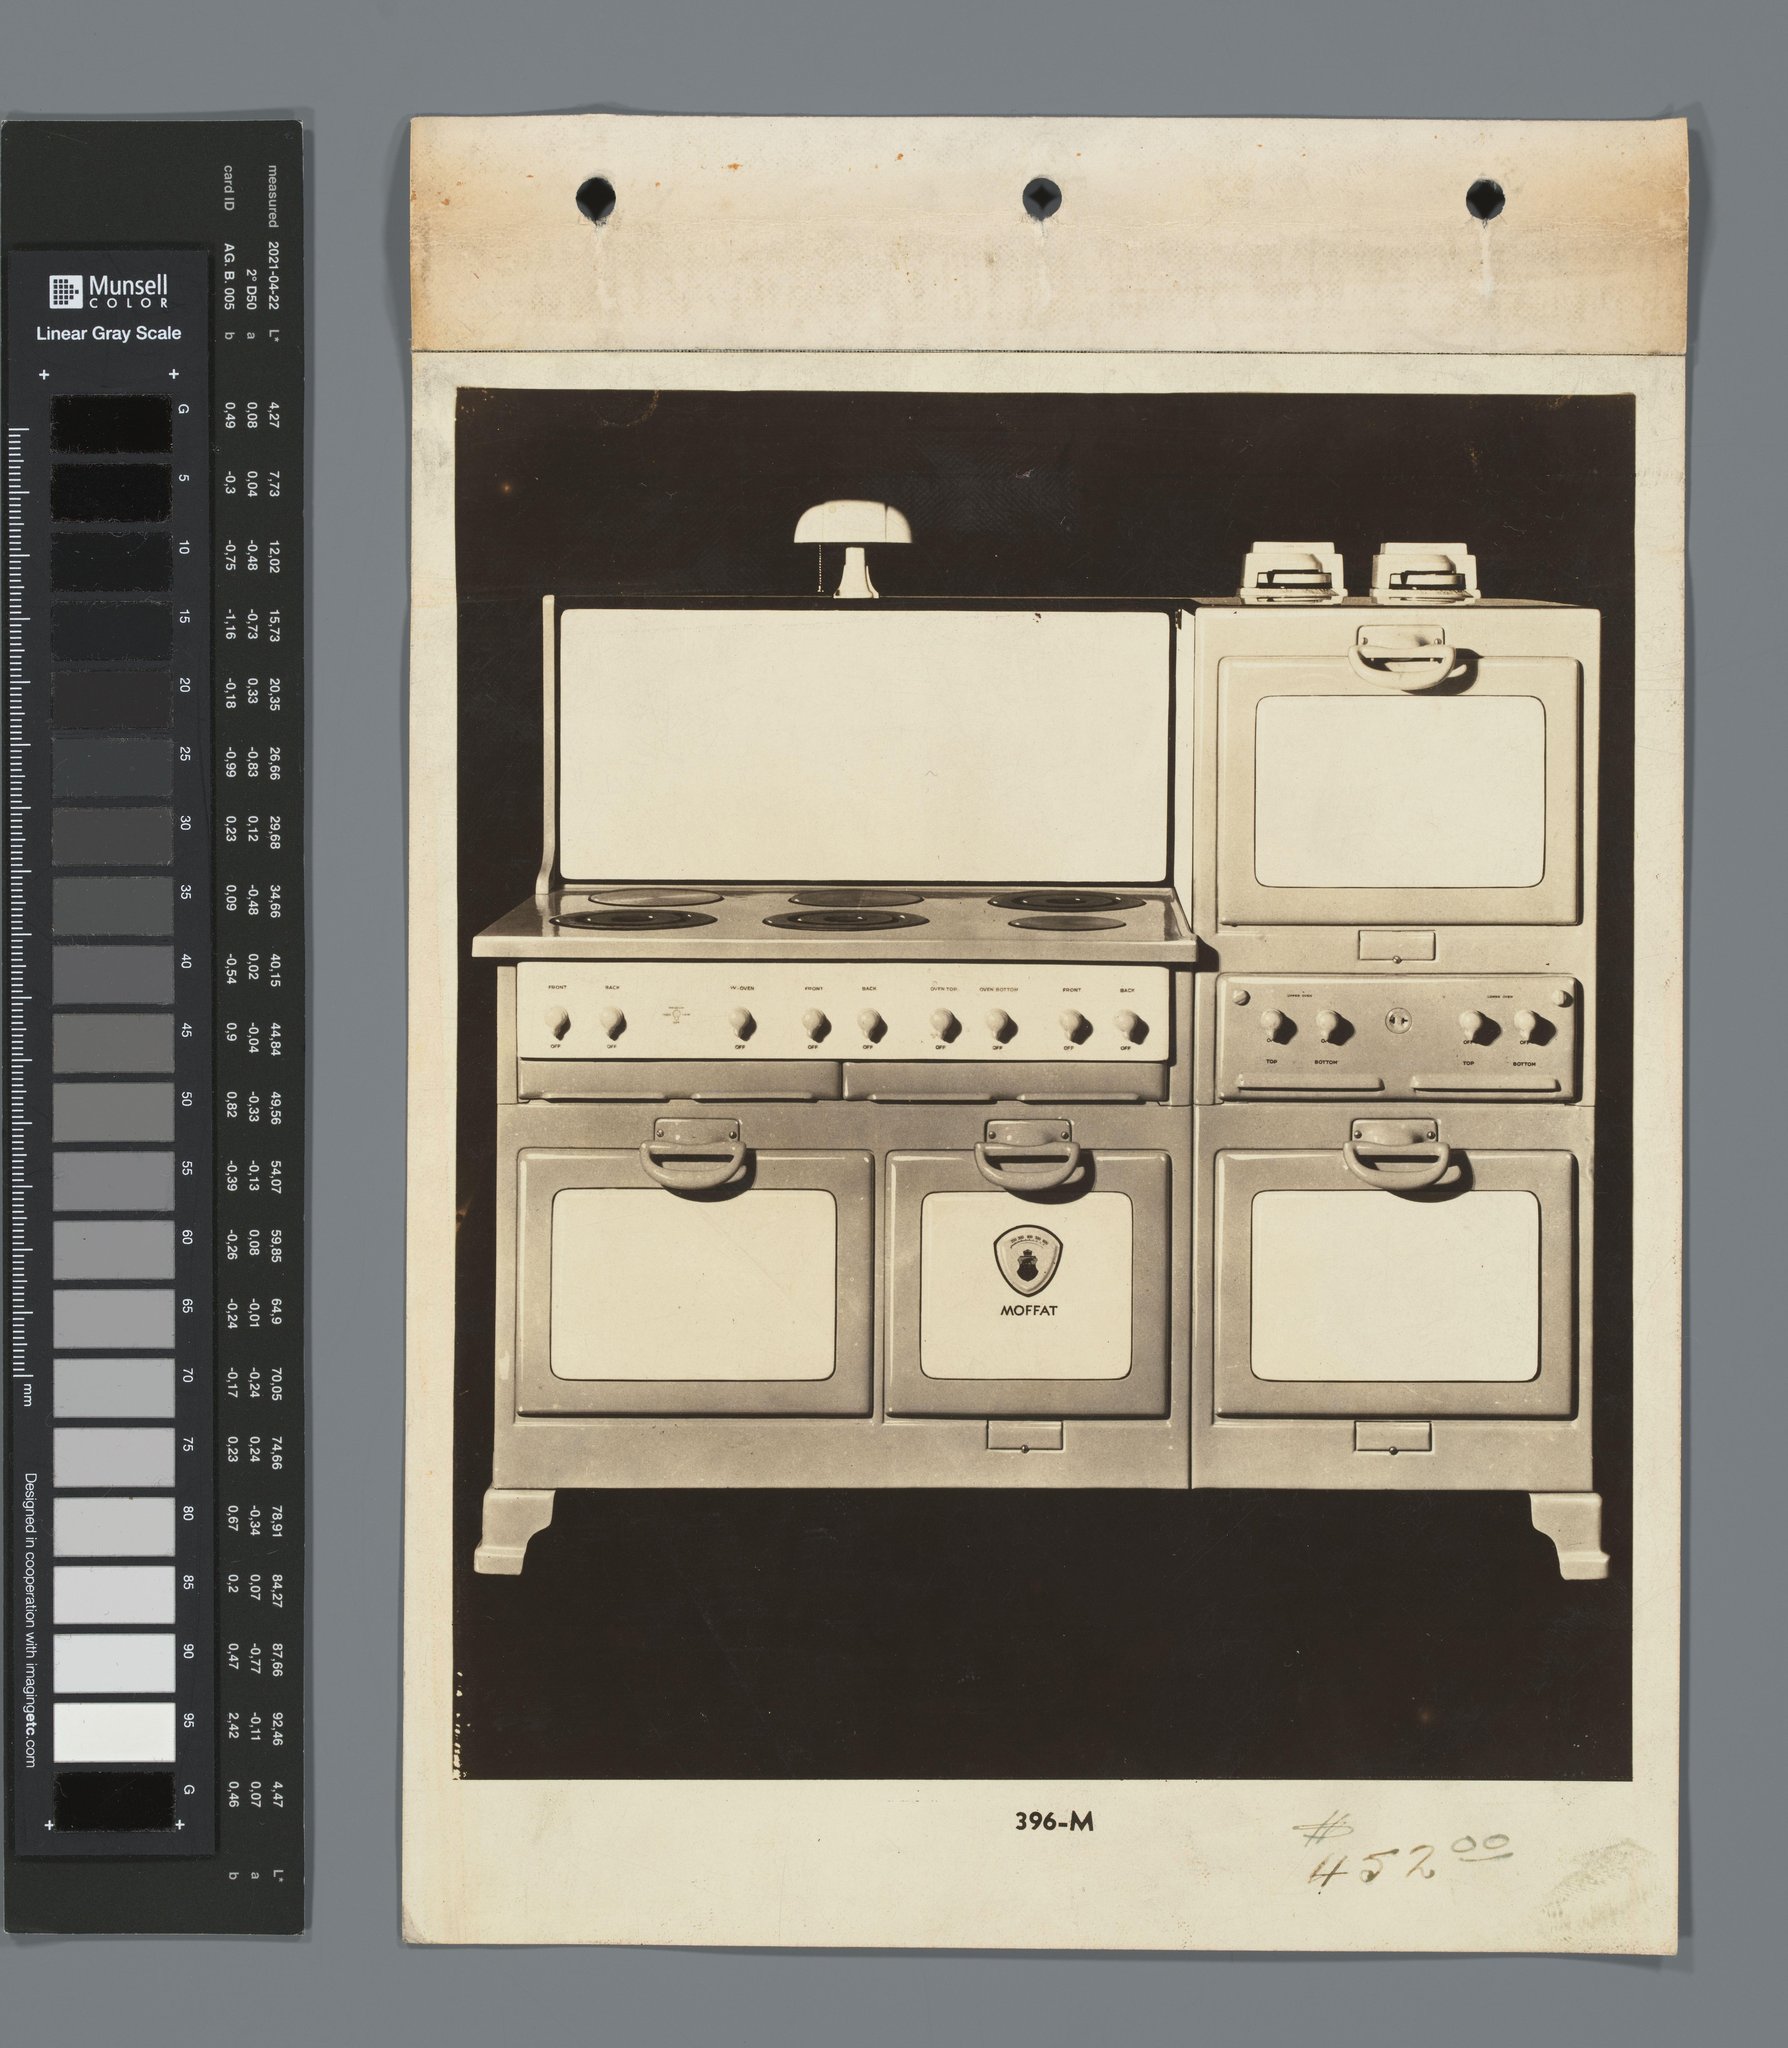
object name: photograph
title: Foto van Moffat ovens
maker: Anonymous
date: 1935-1940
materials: paper, photographic support, textile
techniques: gelatin silver print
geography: canada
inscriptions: inscription: ‘396-M’, inscription: ‘$ 45200’